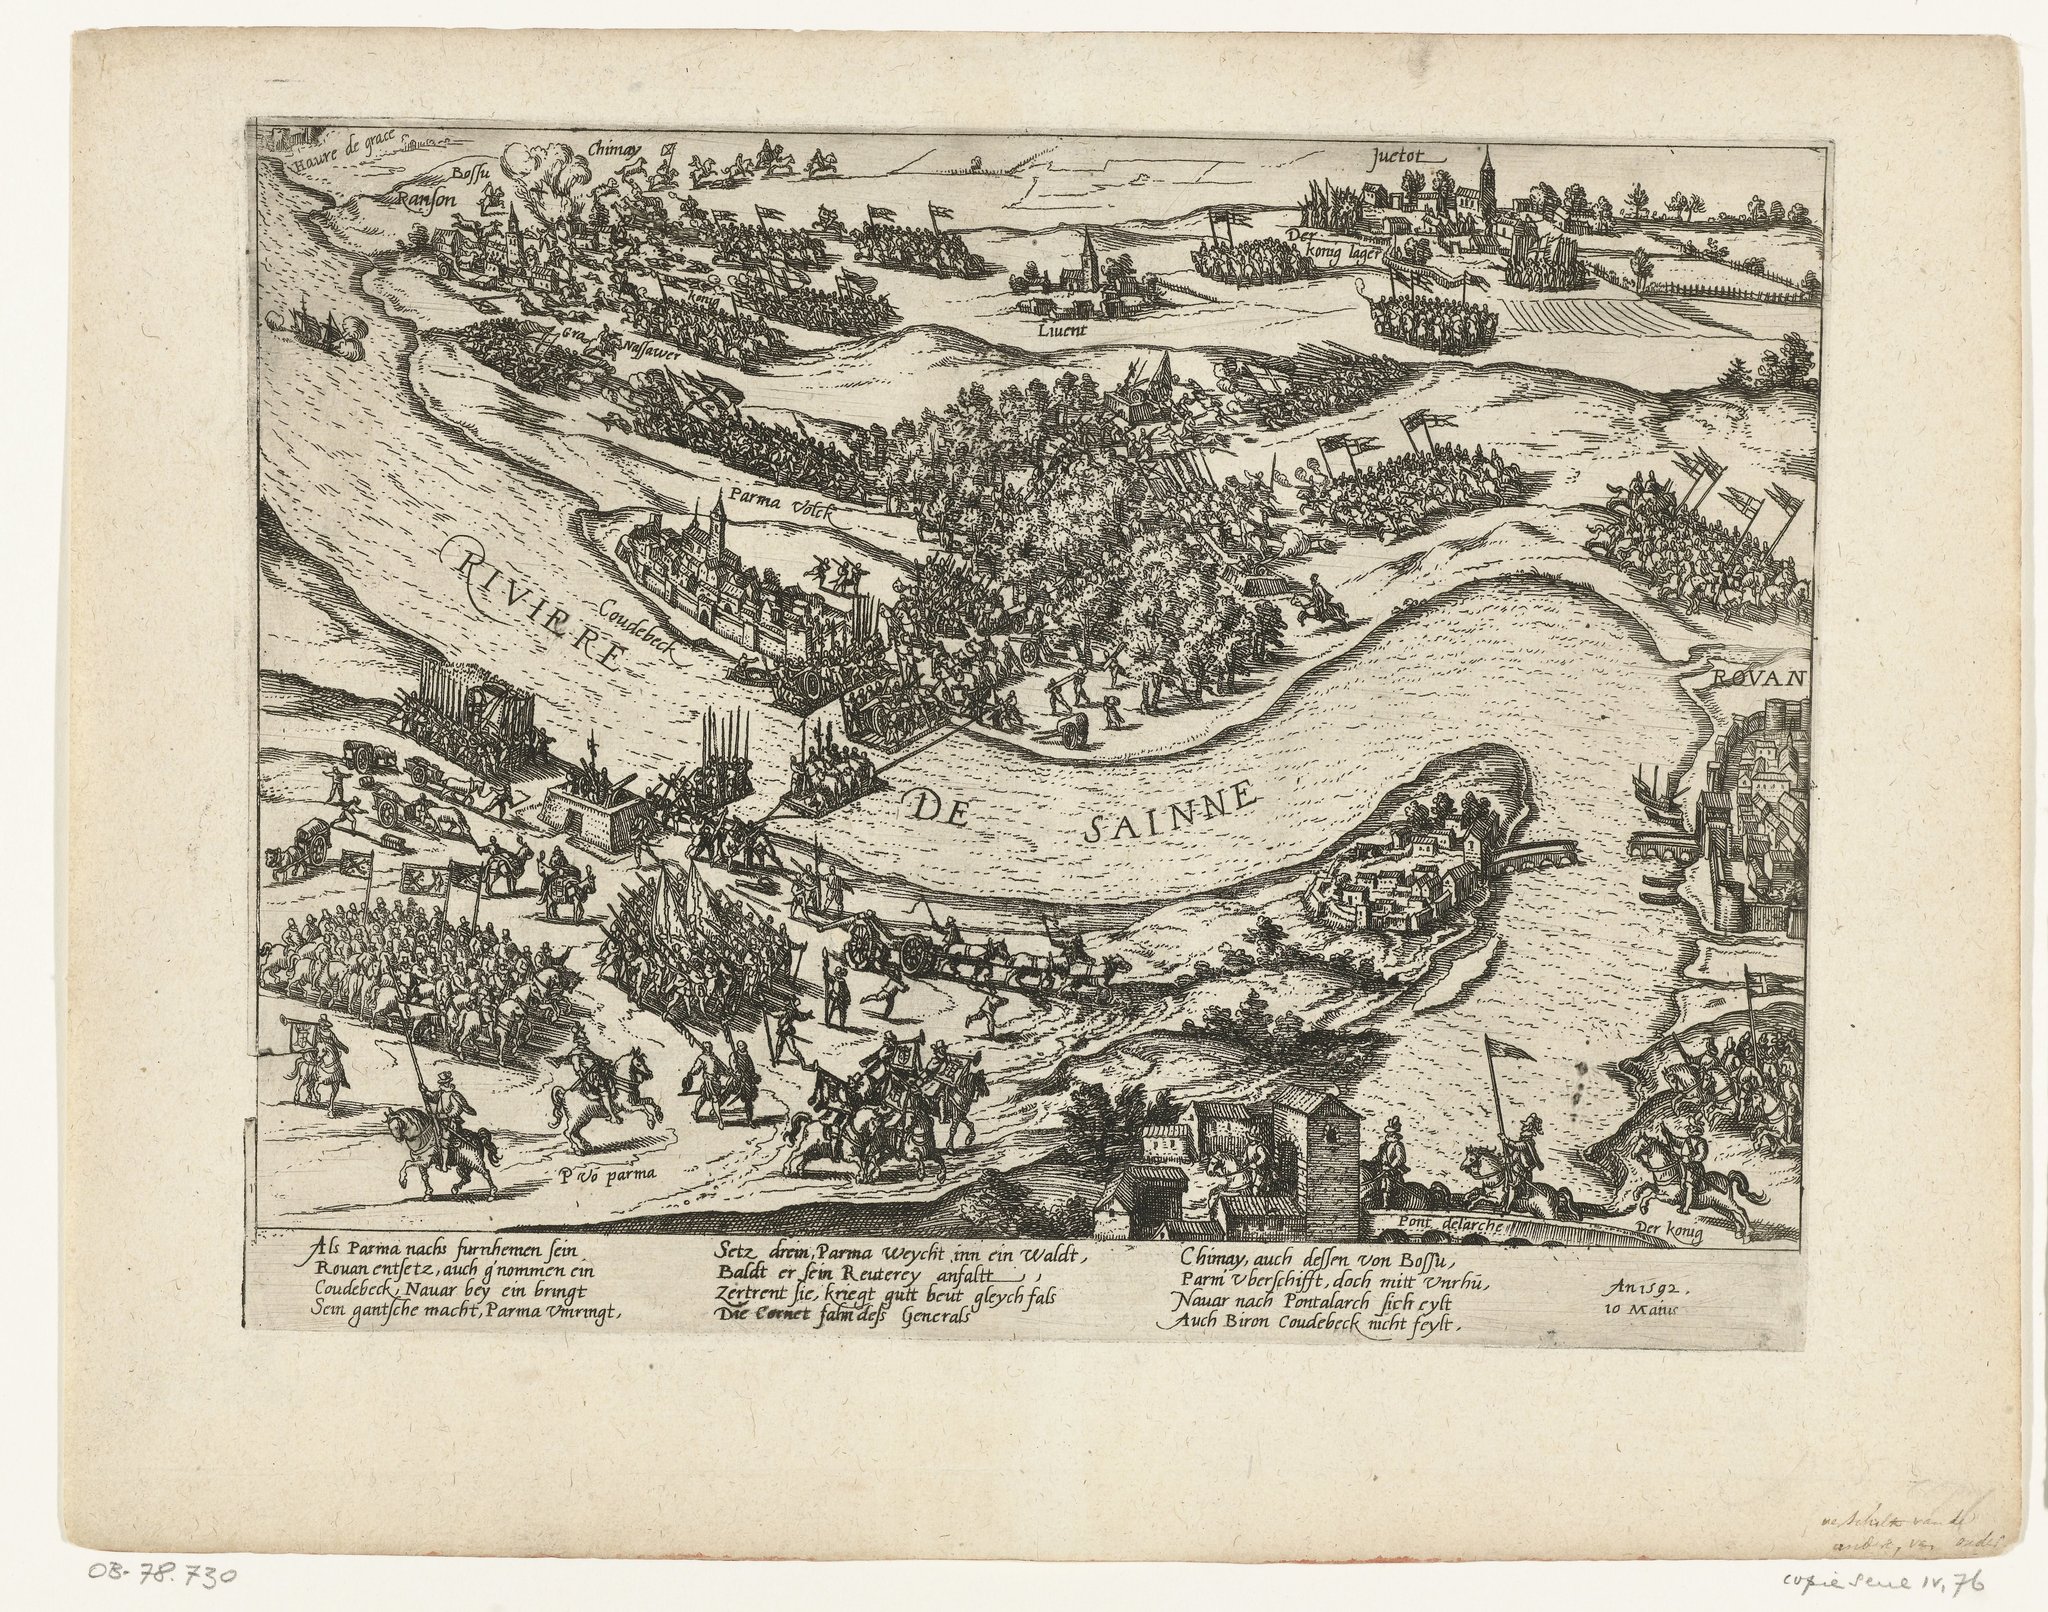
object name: print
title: Parma steekt bij Caudebec de Seine over, 1592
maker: frans hogenberg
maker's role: print maker, publisher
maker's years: 1538-1590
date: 1592-1594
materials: paper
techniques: etching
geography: cologne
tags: rome, alessandro farnese (landvoogd van de nederlanden en hertog van parma en piacenza), paris, hendrik iv (koning van frankrijk en navarra), improvised bridge, temporary bridge ~ military engineering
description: Het leger van de hertog van Parma steekt op vlotten bij Caudebec de Seine over, 10 mei 1592. Rechts onder Rouen en koning Hendrik IV. Met onderschrift van 12 regels in het Duits. Ongenummerd. Papier met rode randjes. Kopie of herhaling naar de prent van Hogenberg.